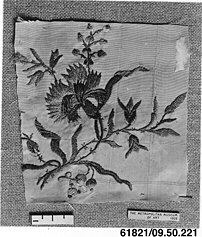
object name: fragment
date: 1701-1800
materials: metal thread, silk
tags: flowers